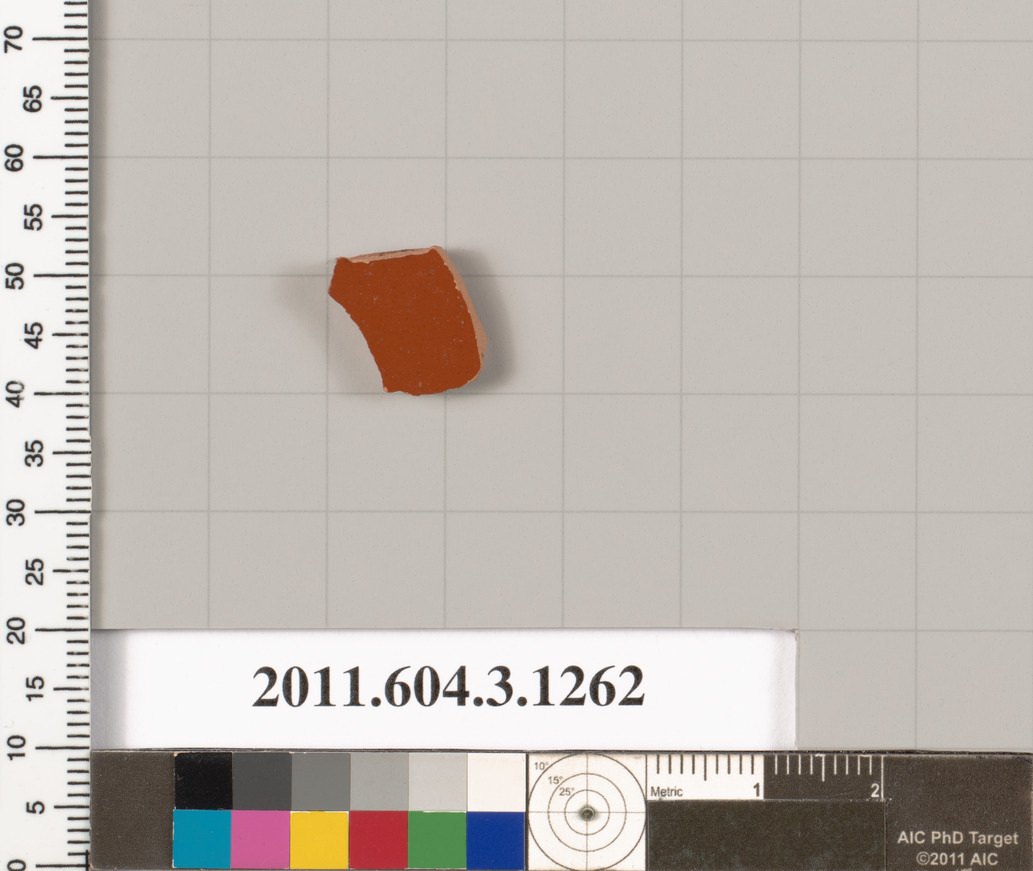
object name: undetermined shape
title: Terracotta fragment of an undetermined shape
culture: greek, attic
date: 600-401 BCE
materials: terracotta